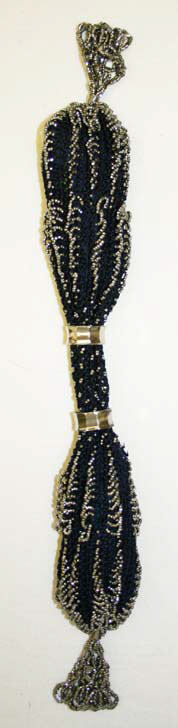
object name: miser's purse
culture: british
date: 1834-1866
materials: silk